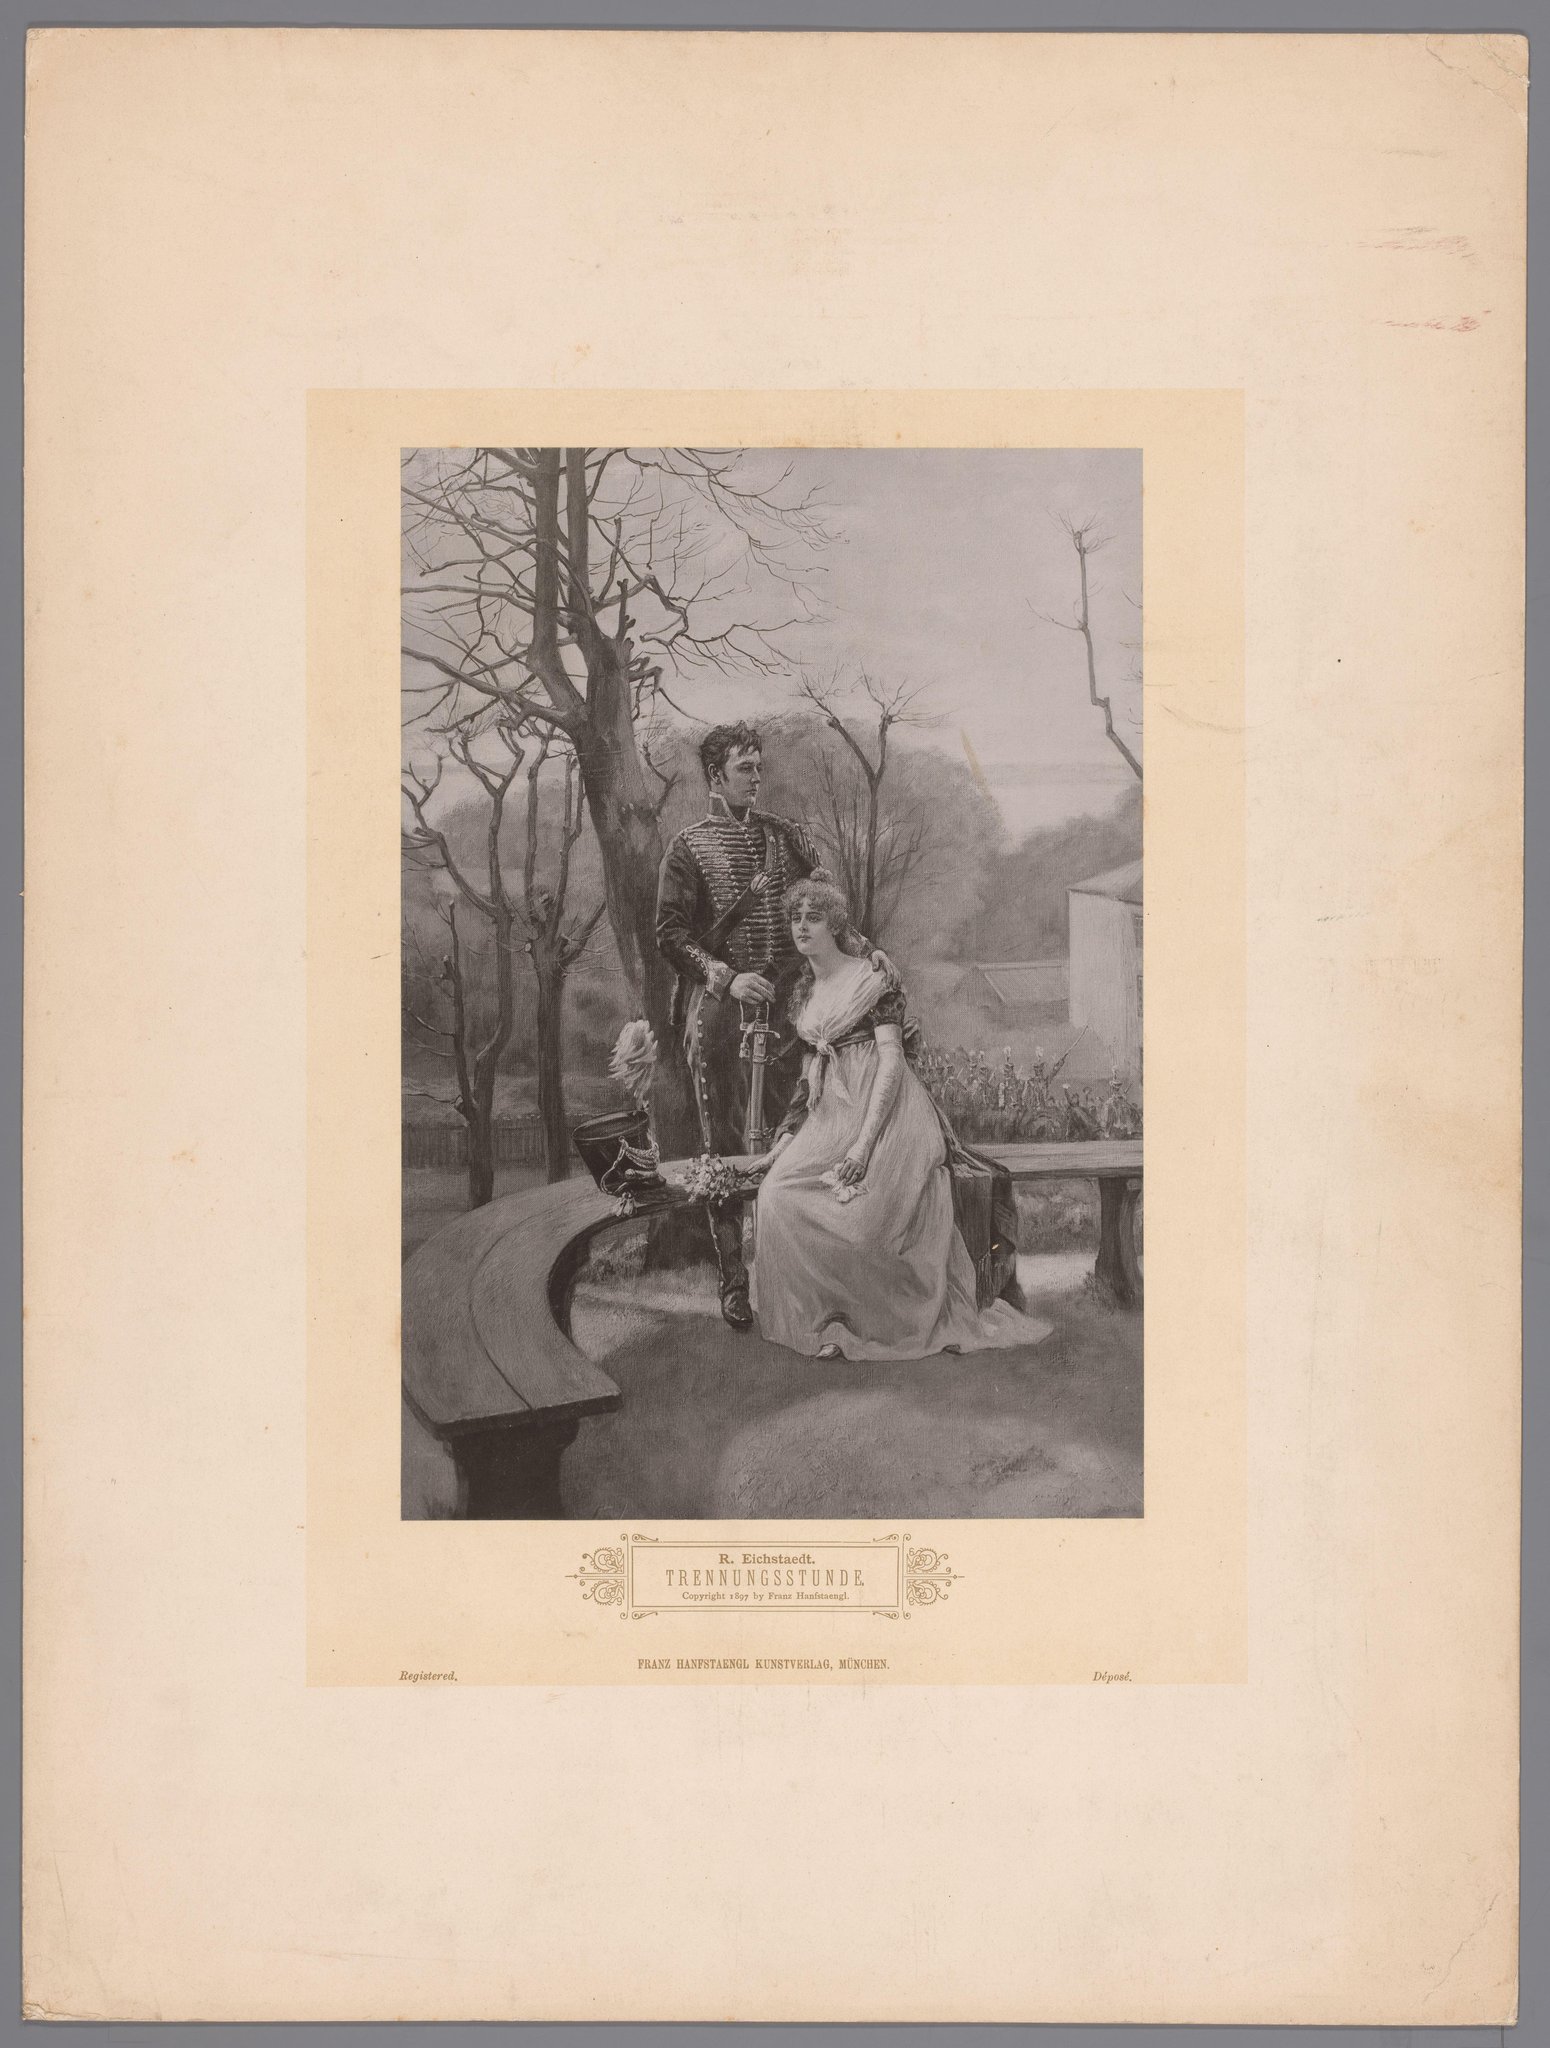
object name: photograph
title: Reproductie van schilderij "Trennungsstunde" van R. Eichstadt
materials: cardboard, paper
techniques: albumen print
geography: munich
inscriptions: caption: ‘R. Eichstadt//TRENNUNGSSTUNDE//Copyright 1897 by Franz Hanfstaengl.//Registered//FRANZ HANFSTAENGL KUNSTVERLAG, MÜNCHEN//Registered//Déposé’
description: Genretafereel van een elkaar vasthoudende man en vrouw op een bank in een landschap of tuin.